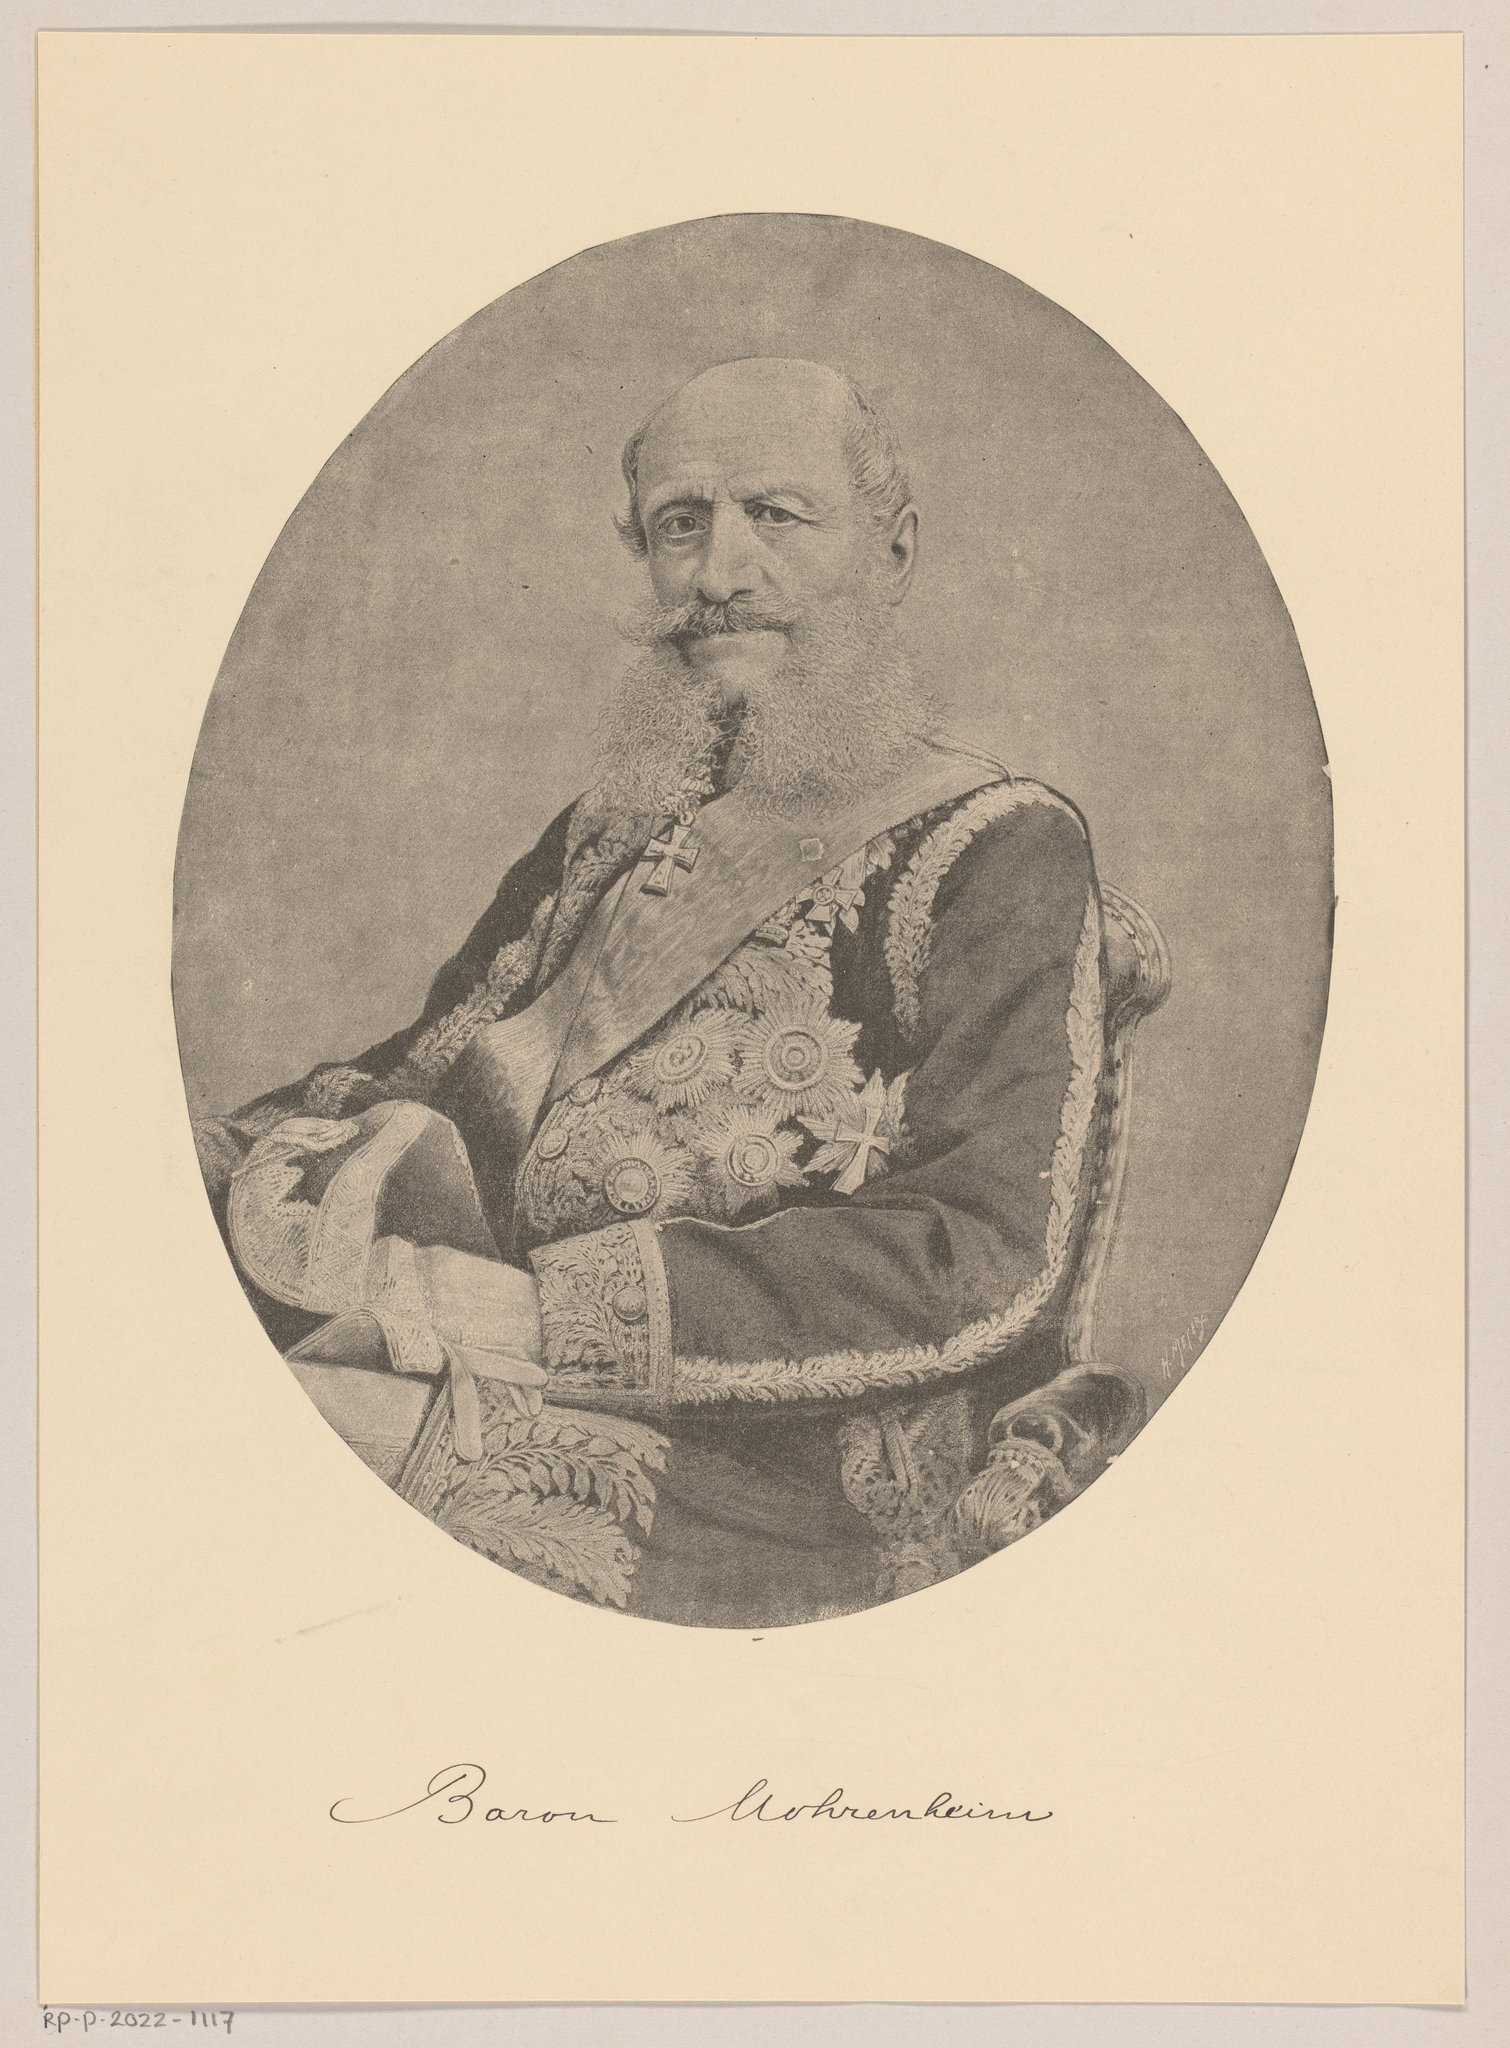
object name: photomechanical print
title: Baron Mohrenheim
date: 1884-1970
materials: paper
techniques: letterpress printing, snipping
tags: historical persons, diplomacy, diplomat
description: Fotomechanische afdruk uit een onbekende publicatie.